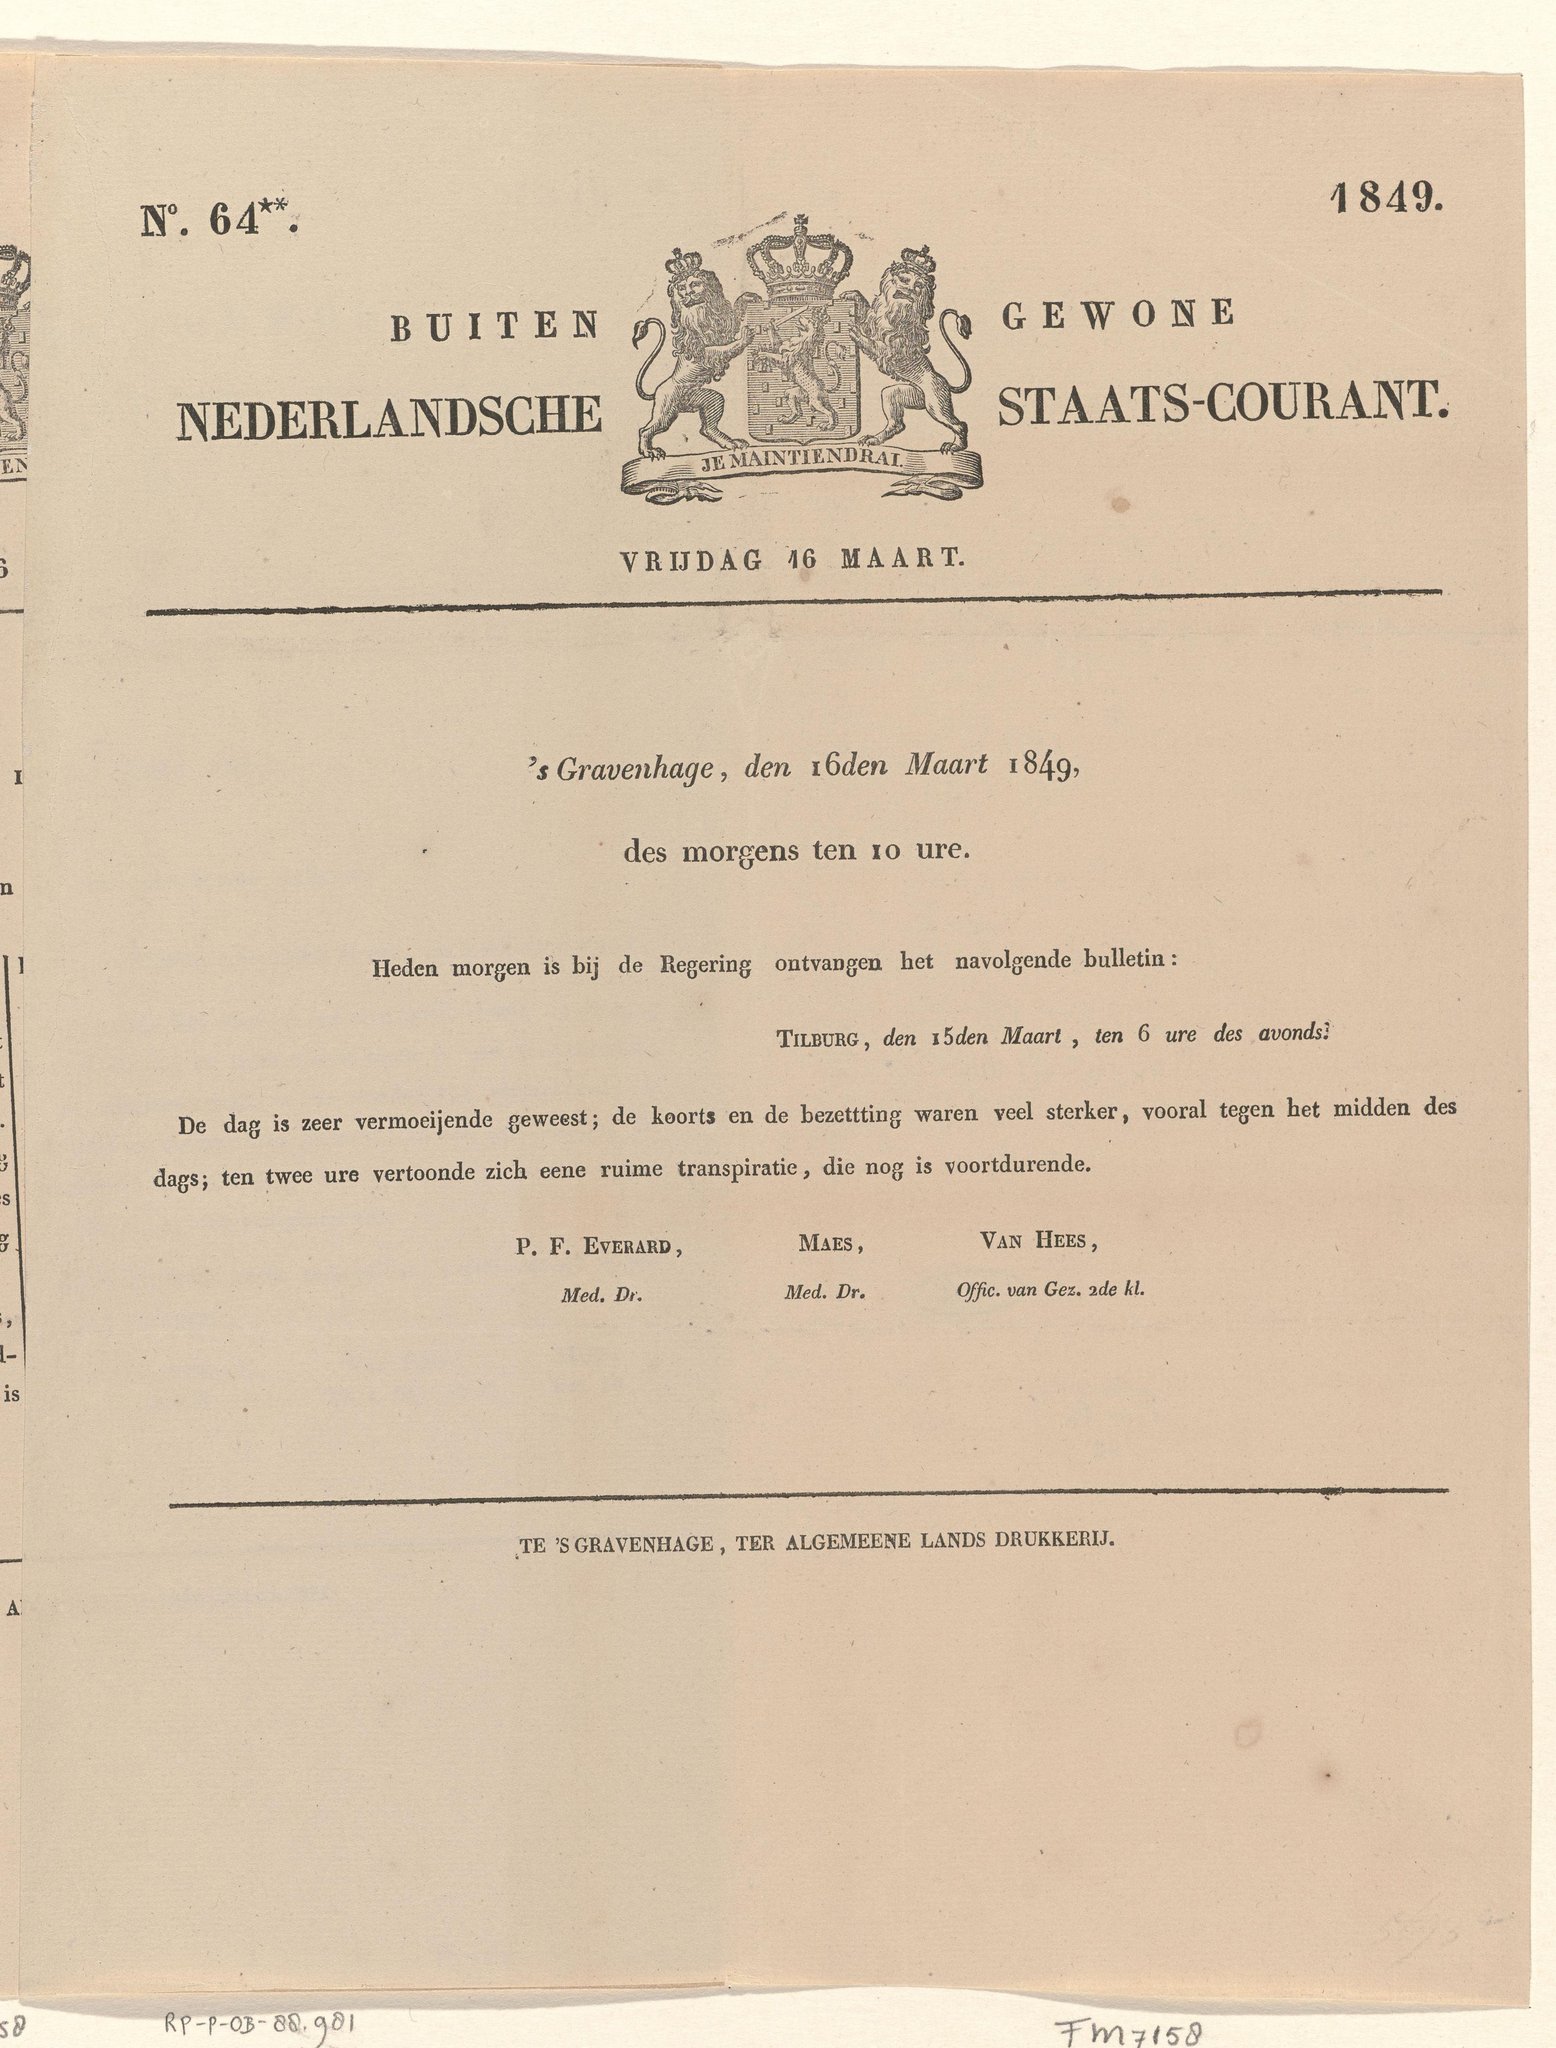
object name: newspaper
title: Buiten Gewone Nederlandsche Staats-Courant. Vrijdag 16 Maart. N. 64**. 1849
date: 1849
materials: paper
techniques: letterpress printing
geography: the hague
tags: william ii of the netherlands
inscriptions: collector's mark: Lugt 2228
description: Exemplaar van de Nederlandse Staatscourant van 16 maart 1849 met de publicatie van een medisch bulletin van 16 maart uit Tilburg over de gezondheid van koning Willem II. Blad bedrukt op één zijde. Bovenaan het rijkswapen.